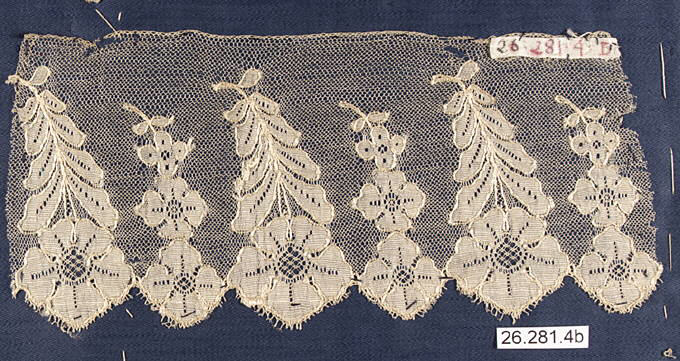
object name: strip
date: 1801-1833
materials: lace, silk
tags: flowers